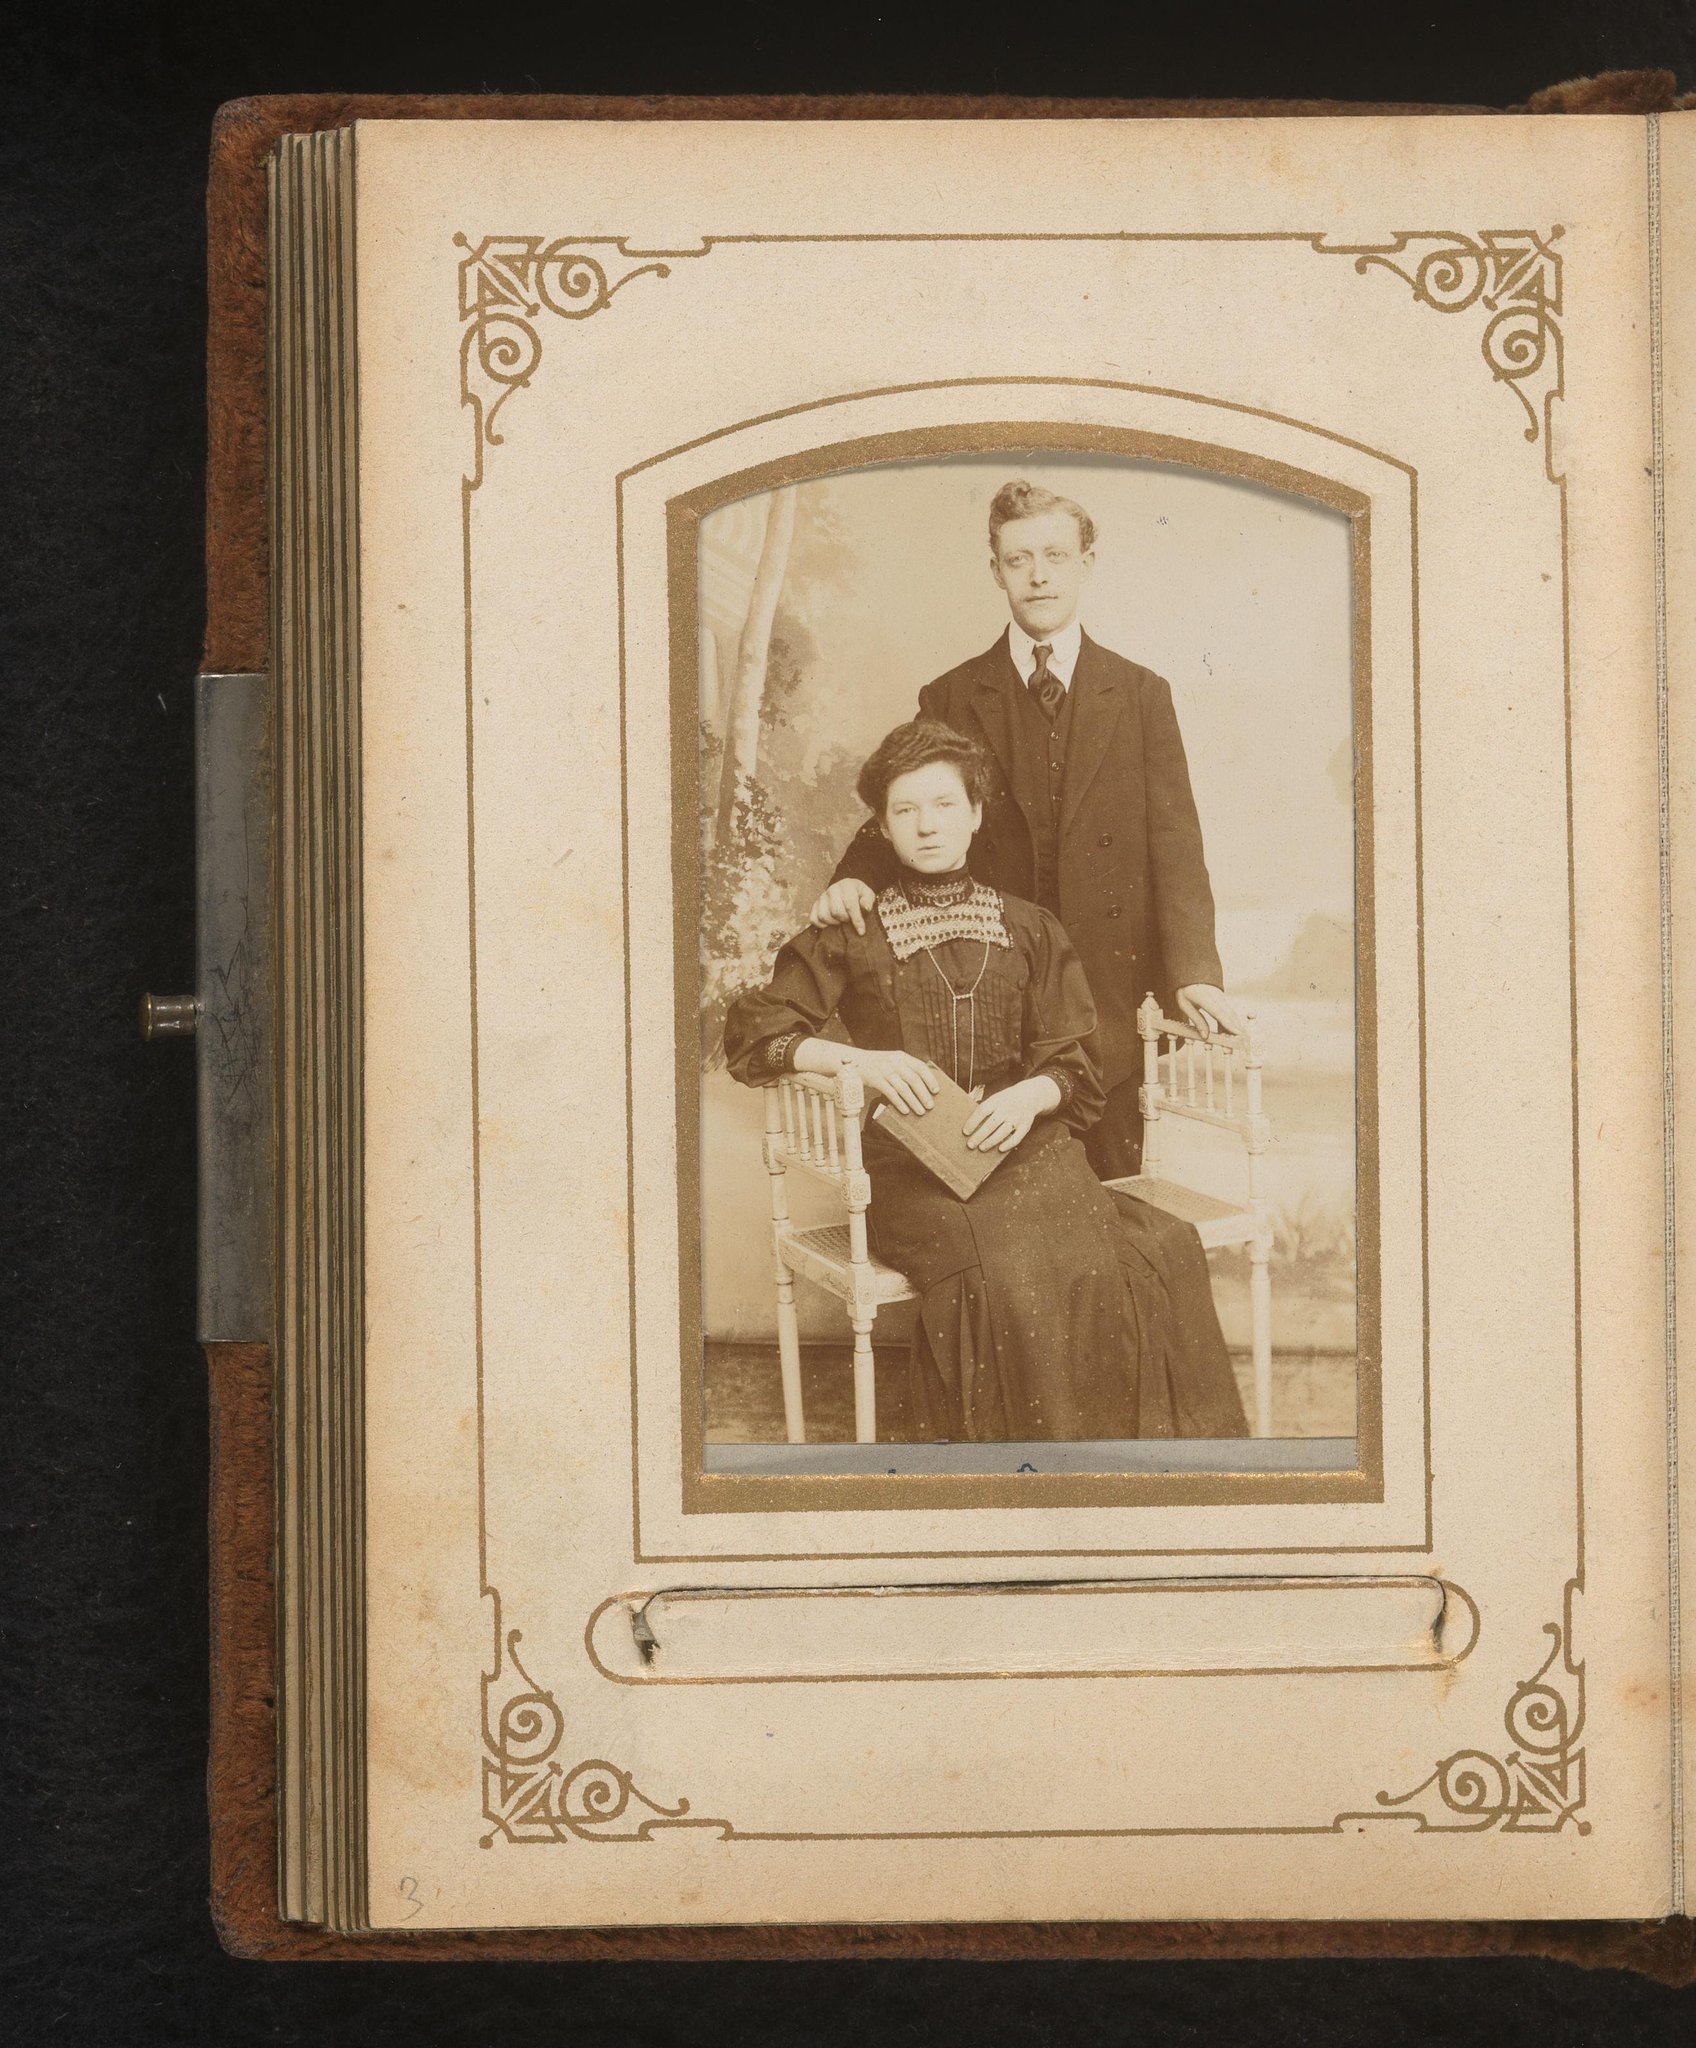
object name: photograph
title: Portret van een man en vrouw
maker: Anonymous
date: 1860-1900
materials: photographic support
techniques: collodion silver print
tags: adult woman, adult man, historical persons